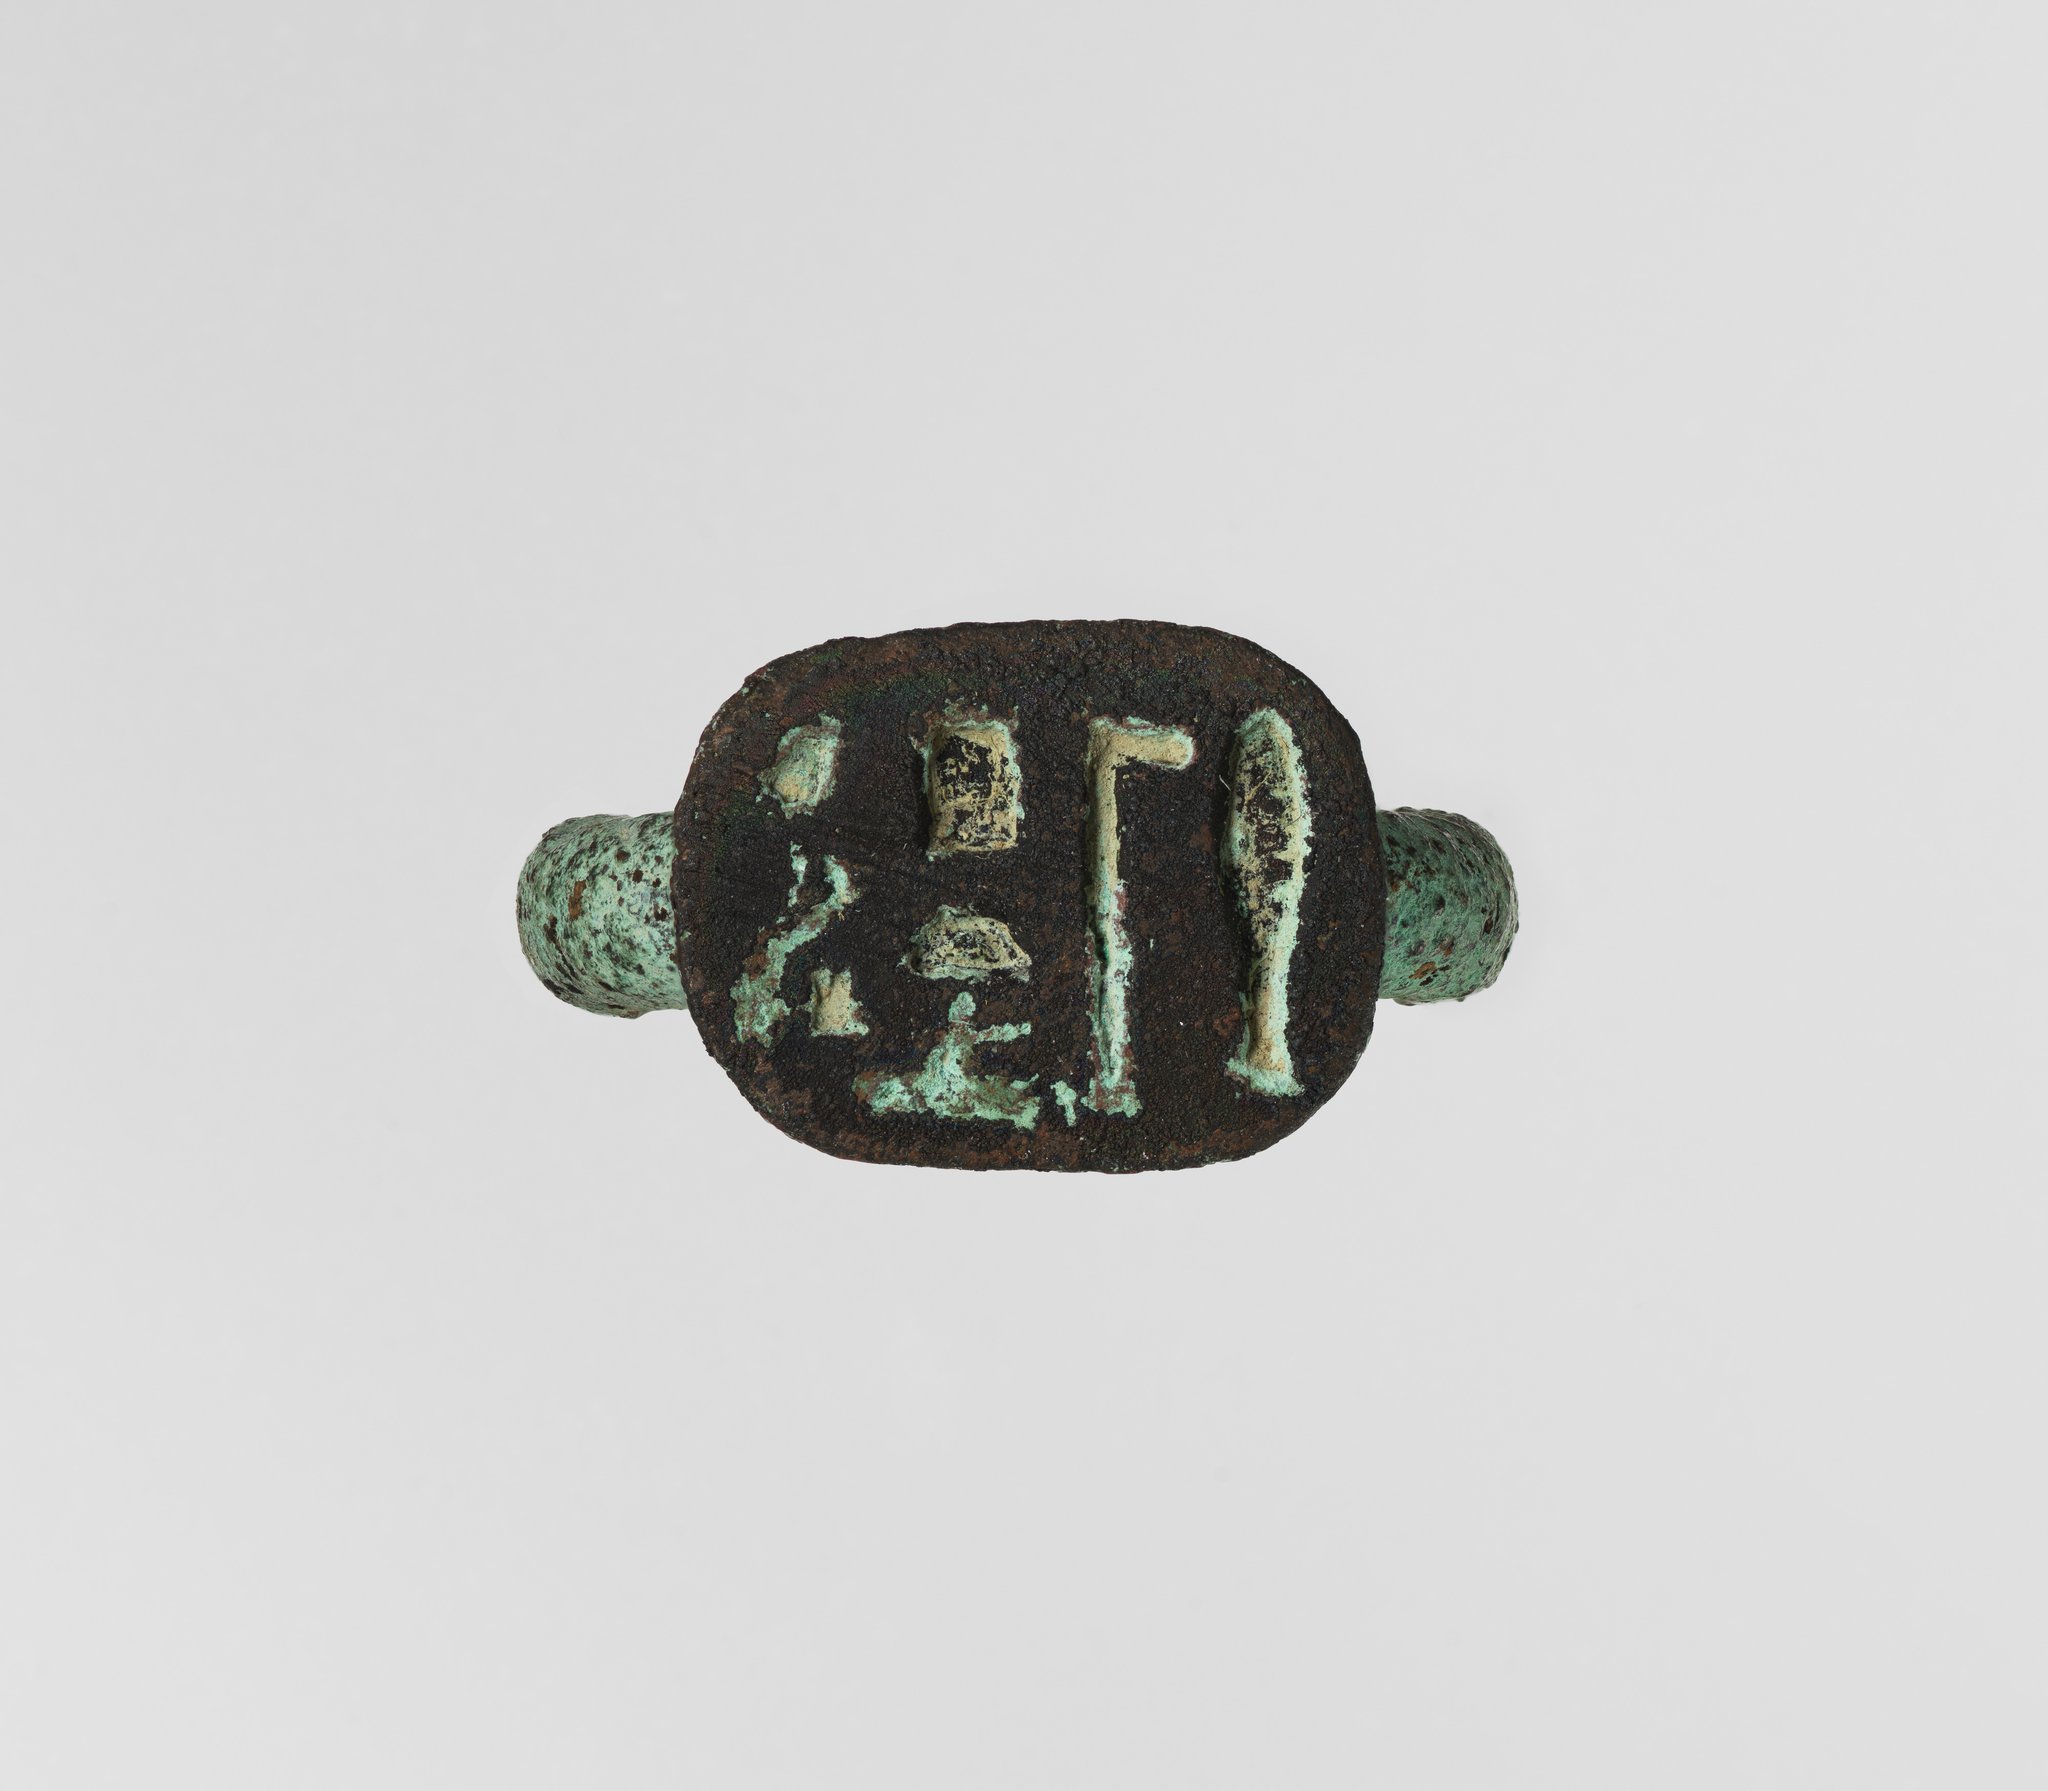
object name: ring, signet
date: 1070-712 BCE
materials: bronze, copper alloy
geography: egypt